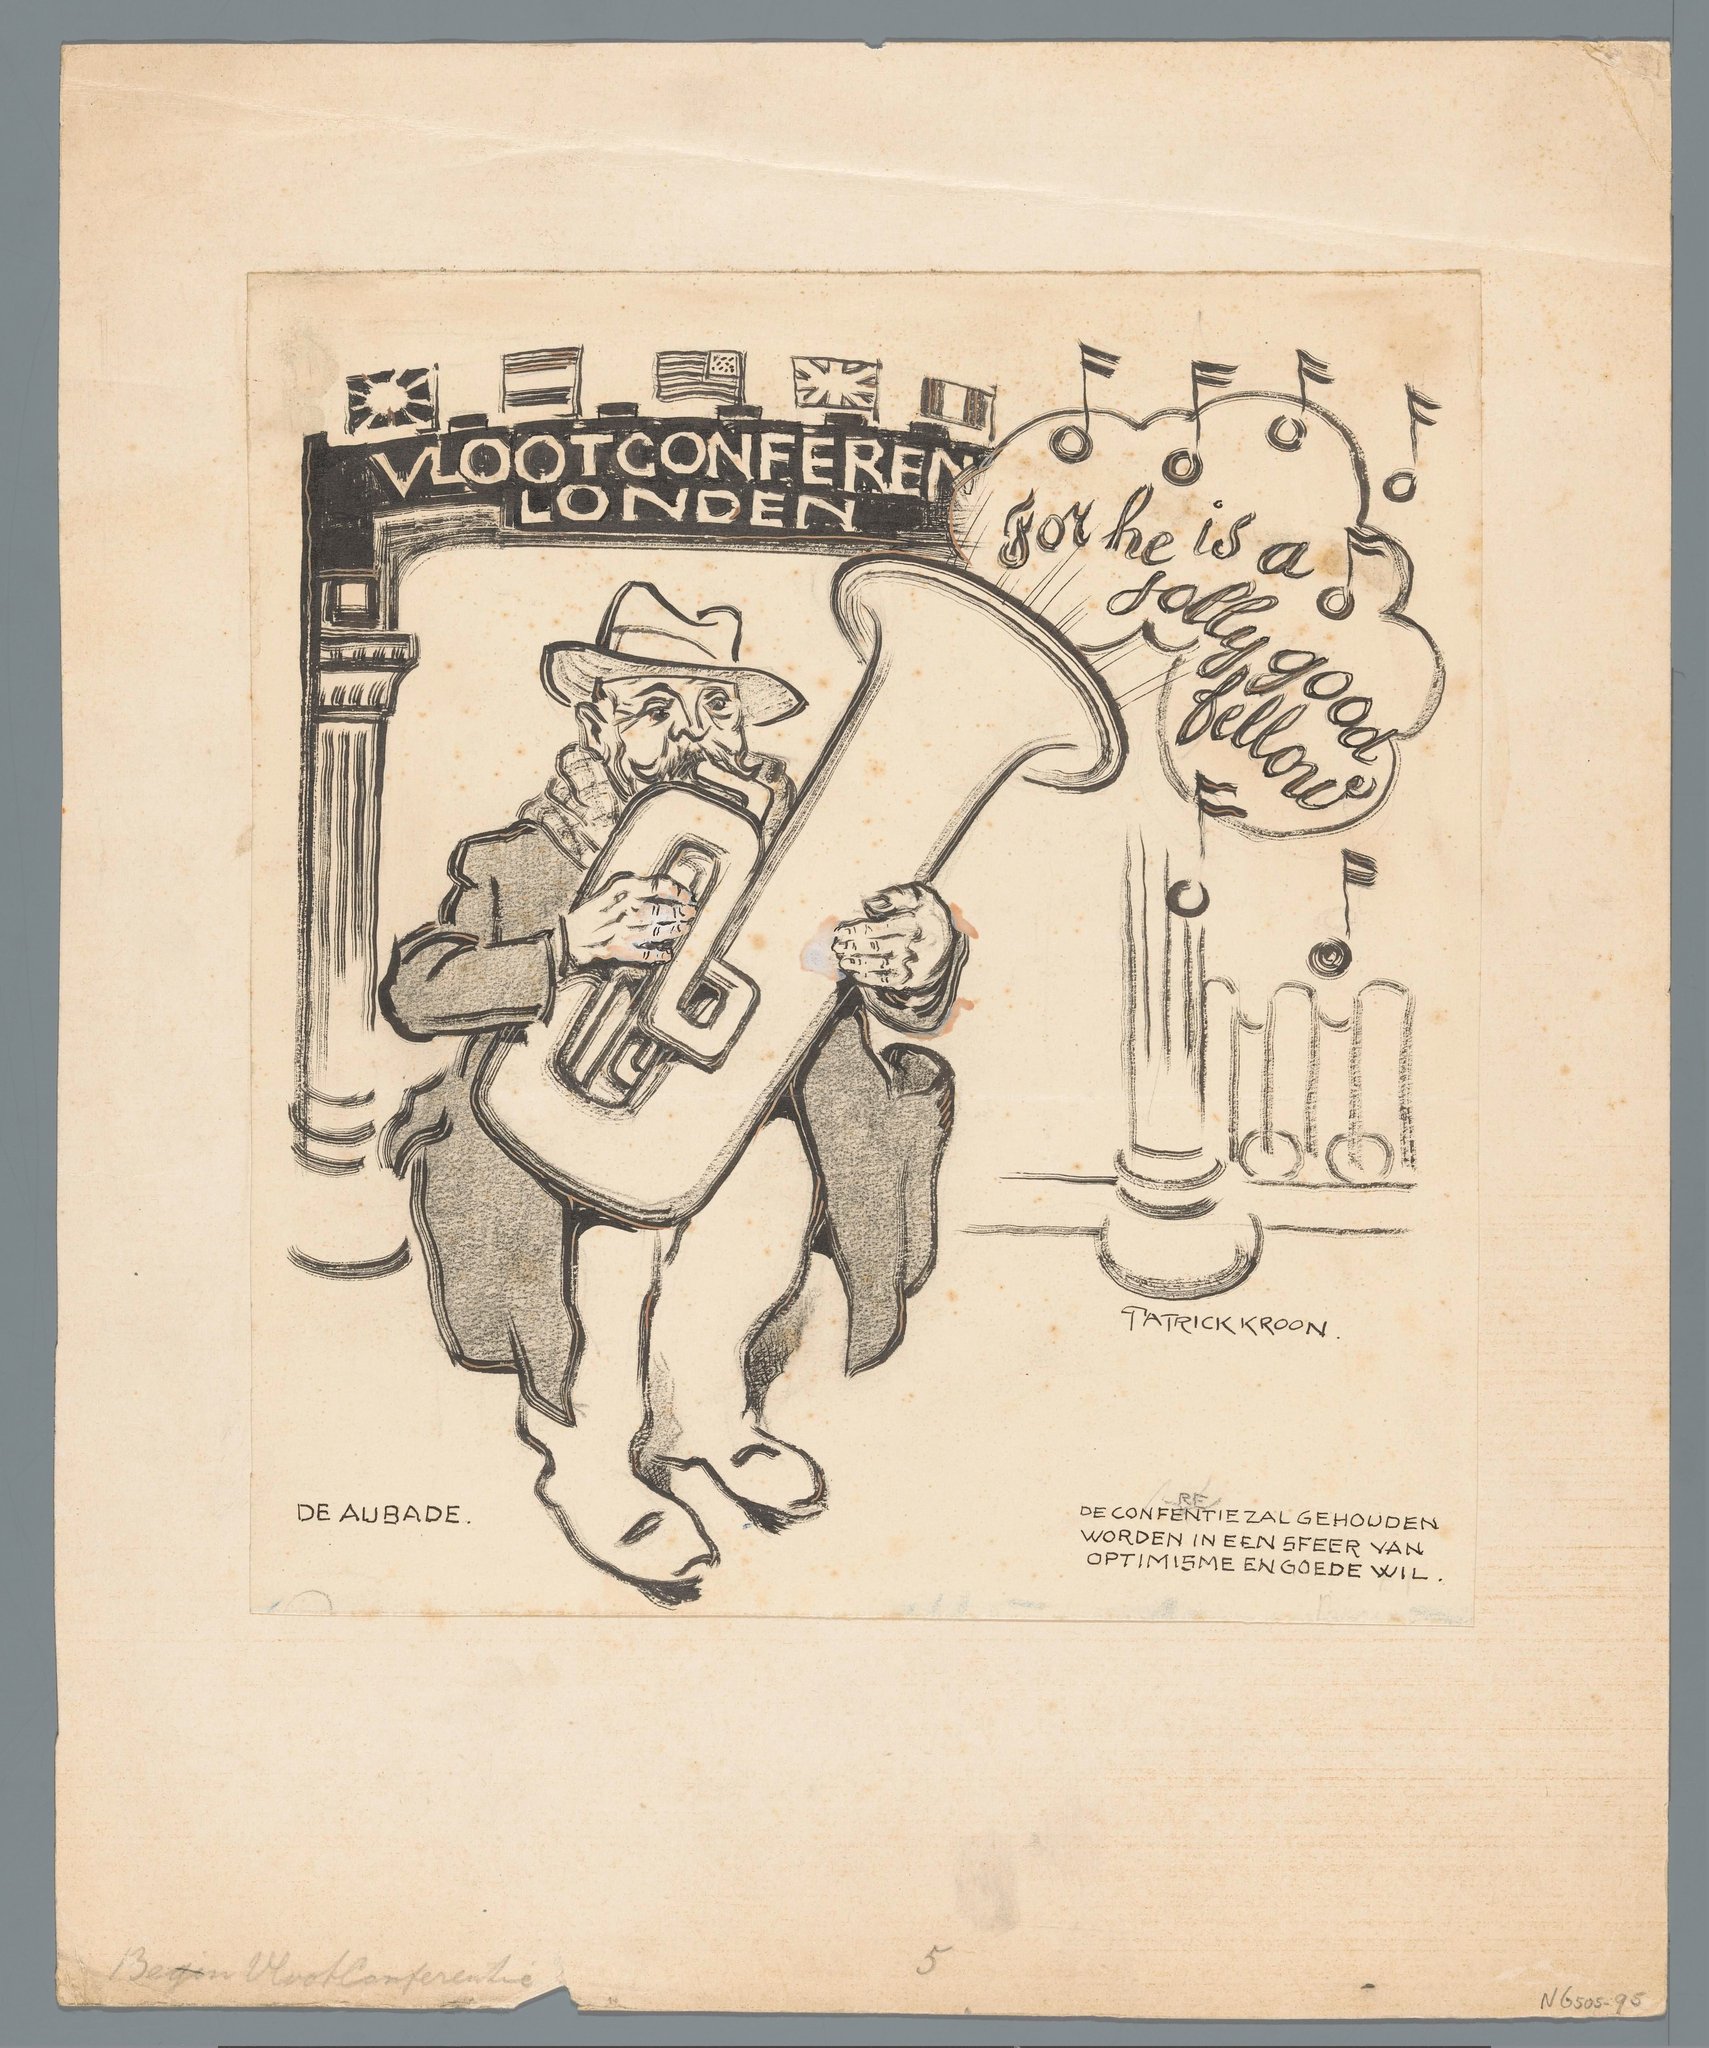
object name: cartoon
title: De Aubade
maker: patricq kroon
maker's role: draughtsman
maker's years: 1862-1941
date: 1935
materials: chalk, ink, paper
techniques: pen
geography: netherlands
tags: horn, trumpet, cornet, trombone, tuba - cc - out of doors, political caricatures and satires, london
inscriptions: inscription: ‘De Aubade / De conferentie zal gehouden worden ...’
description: Het begin van de vlootconferentie in Londen in 1935. Een man blaast op een tuba de melodie van het lied 'For he's a jolly good fellow'. Ontwerp voor een politieke spotprent.